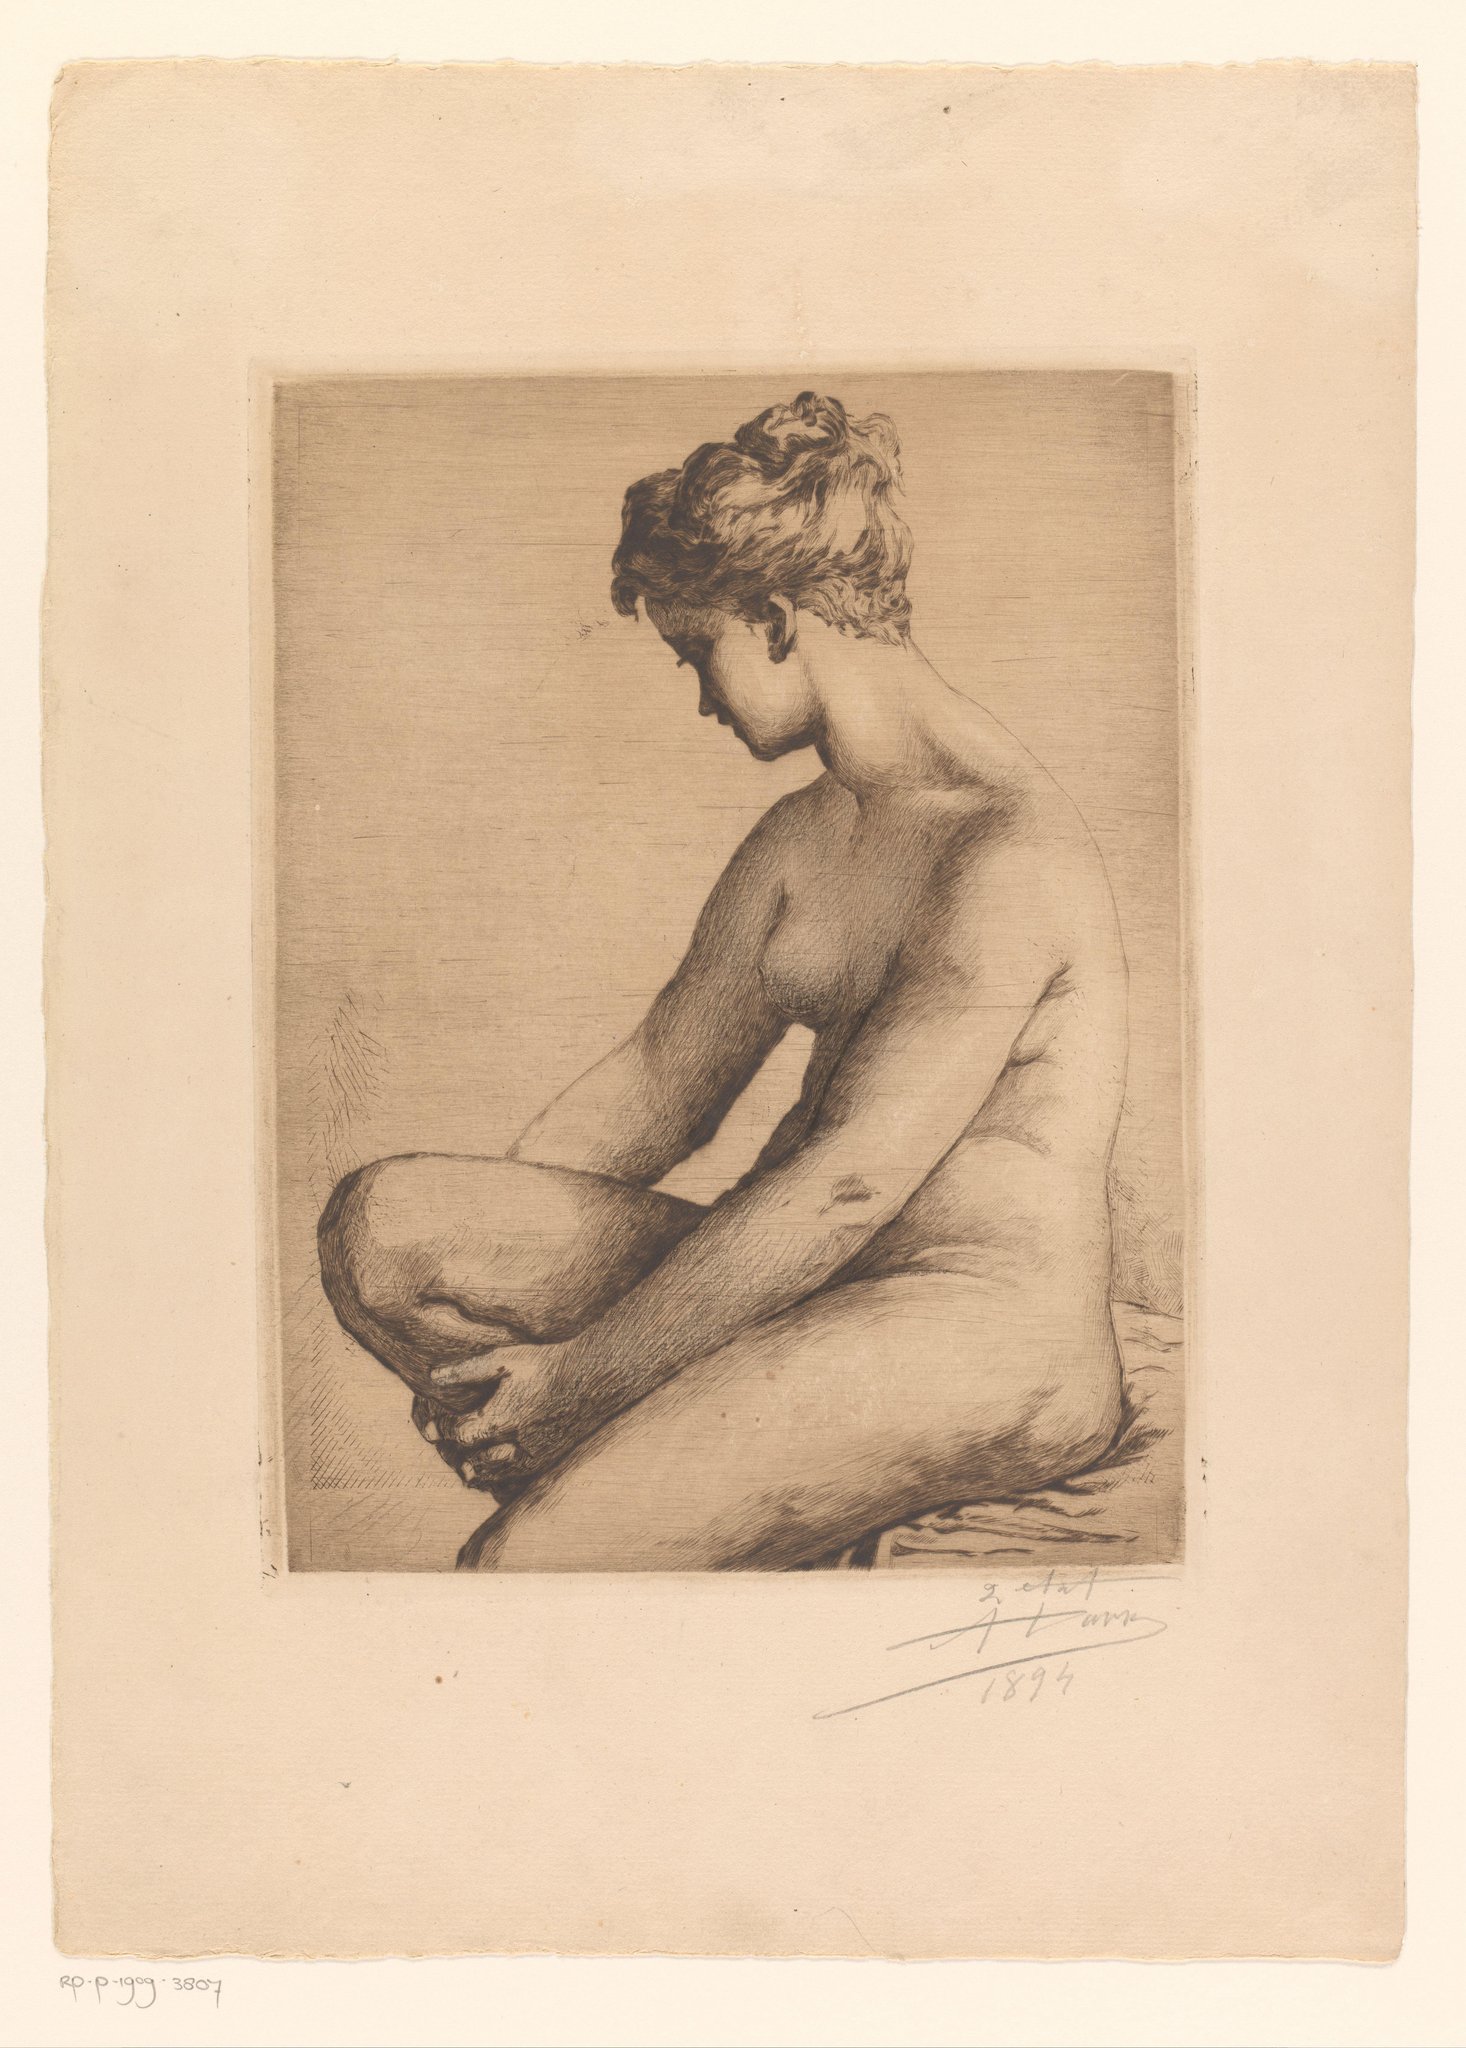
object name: print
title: Zittende naakte jonge vrouw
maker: auguste danse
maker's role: print maker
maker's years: 1829-1929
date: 1894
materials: paper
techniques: drypoint, etching, intaglio, soft ground etching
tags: adolescent, young woman, maiden, woman (showing herself) undressed, quasi-nude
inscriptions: collector's mark: Lugt 2228, annotation: ‘2 etat’